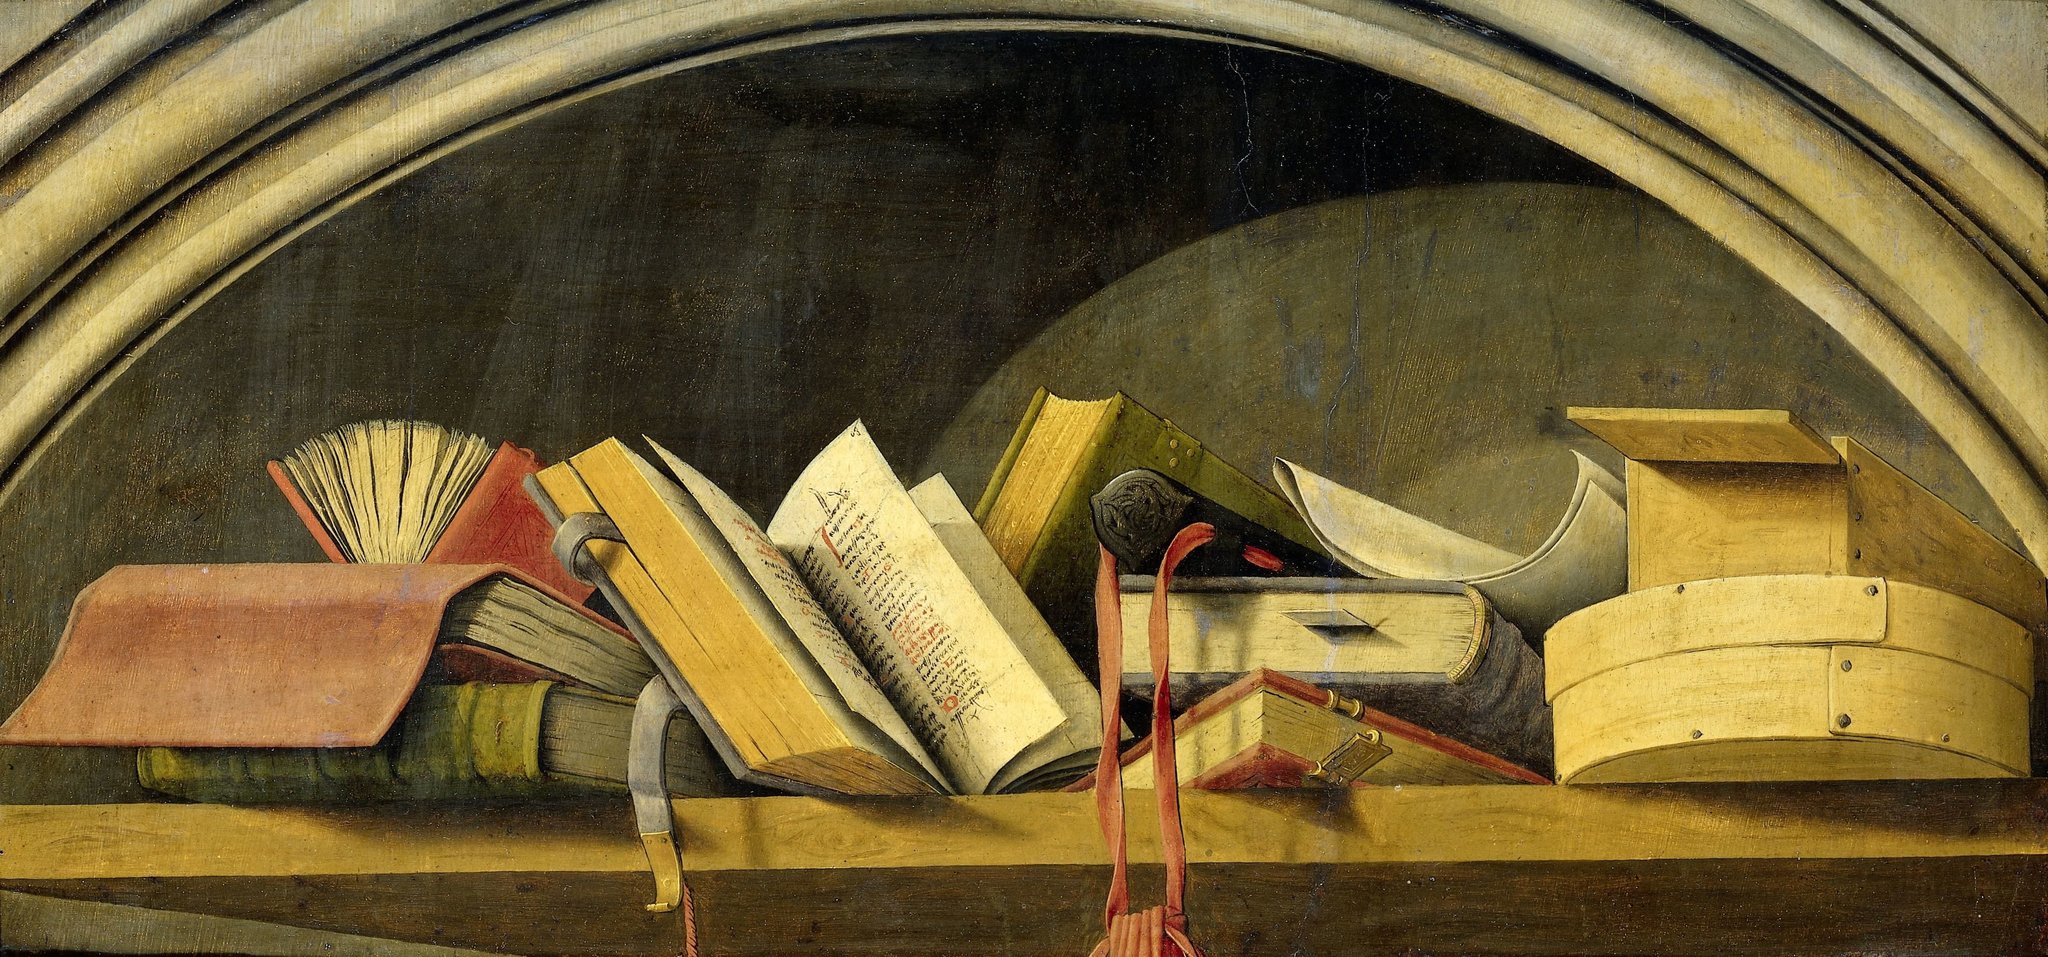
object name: painting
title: Still Life with Books in a Niche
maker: barthélémy d eyck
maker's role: painter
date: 1442-1445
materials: canvas, oil, panel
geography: provence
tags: book - mm - book open, still life of related objects, book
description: Stilleven met verschillende open en gesloten boeken liggend op een plank in een nis. In het midden een pennenkoker, rechts een ronde en een rechthoekige doos. Bovendeel van de linker zijpaneel met de profeet Jesaja, in het Museum Boijmans-Van Beuningen te Rotterdam. Het rechter zijpaneel bevindt zich in het Koninklijk Museum voor de Schone Kunsten te Brussel, het middenpaneel met de verkondiging is in de kerk Ste. Madelaine in Aix-en-Provence.